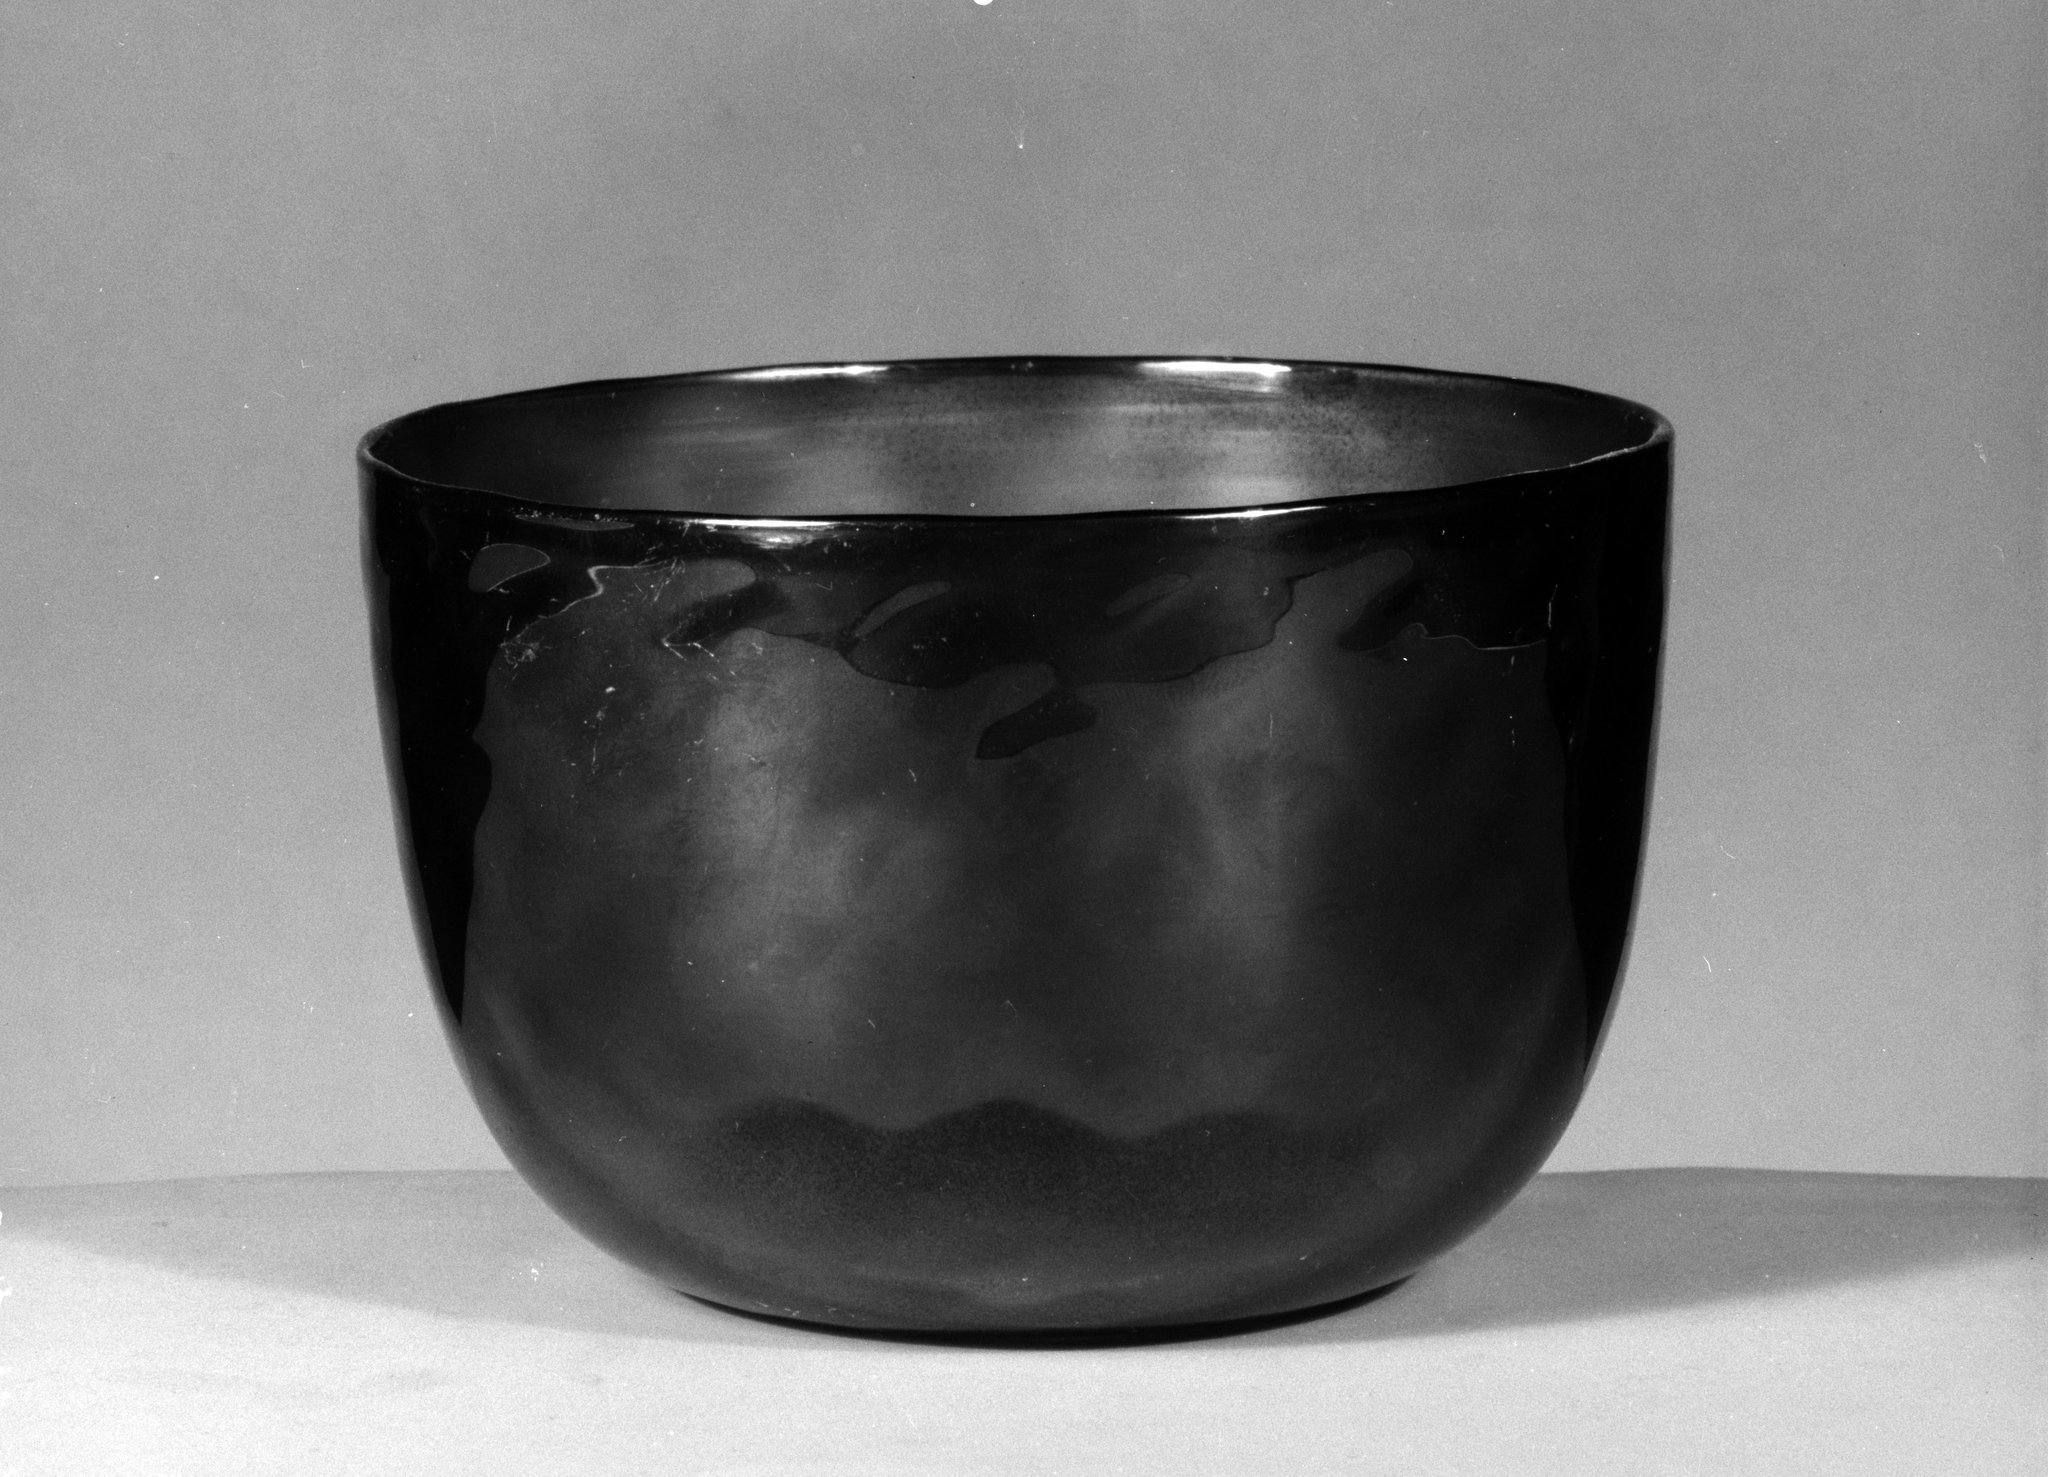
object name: finger bowl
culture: american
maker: new england glass company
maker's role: maker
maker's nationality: american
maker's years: 1818-1888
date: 1886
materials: glass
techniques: glassblowing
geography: united states